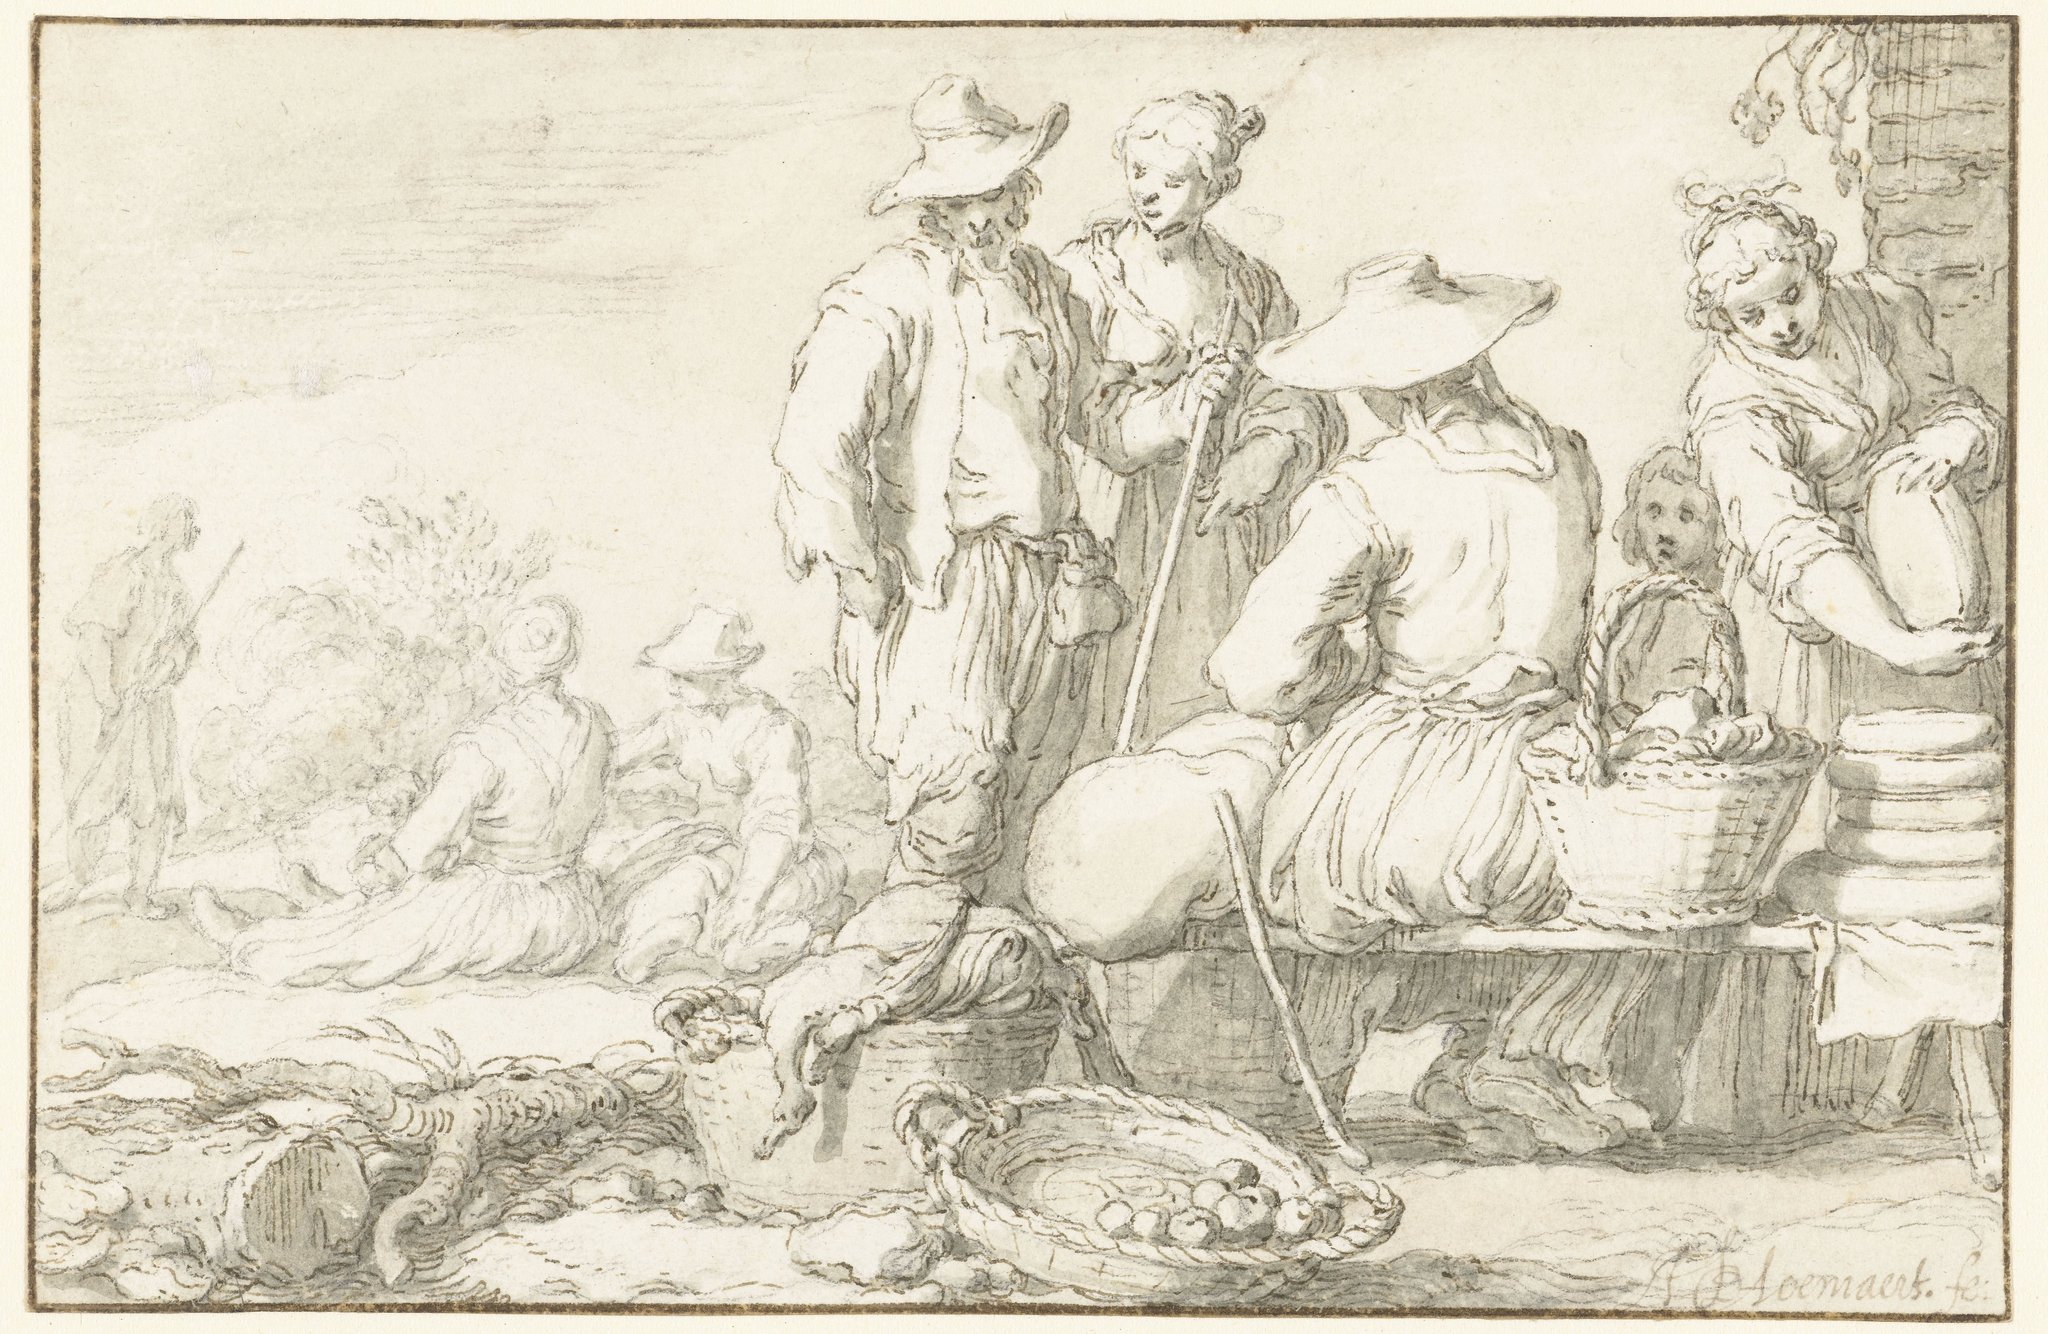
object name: drawing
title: Marktvrouw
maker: abraham bloemaert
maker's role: draughtsman, painter, print maker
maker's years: 1566-1651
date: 1574-1651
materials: chalk, ink, paper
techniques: brush, pen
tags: persons engaged in trade and commerce - bb - women engaged in trade and commerce, market, cheese